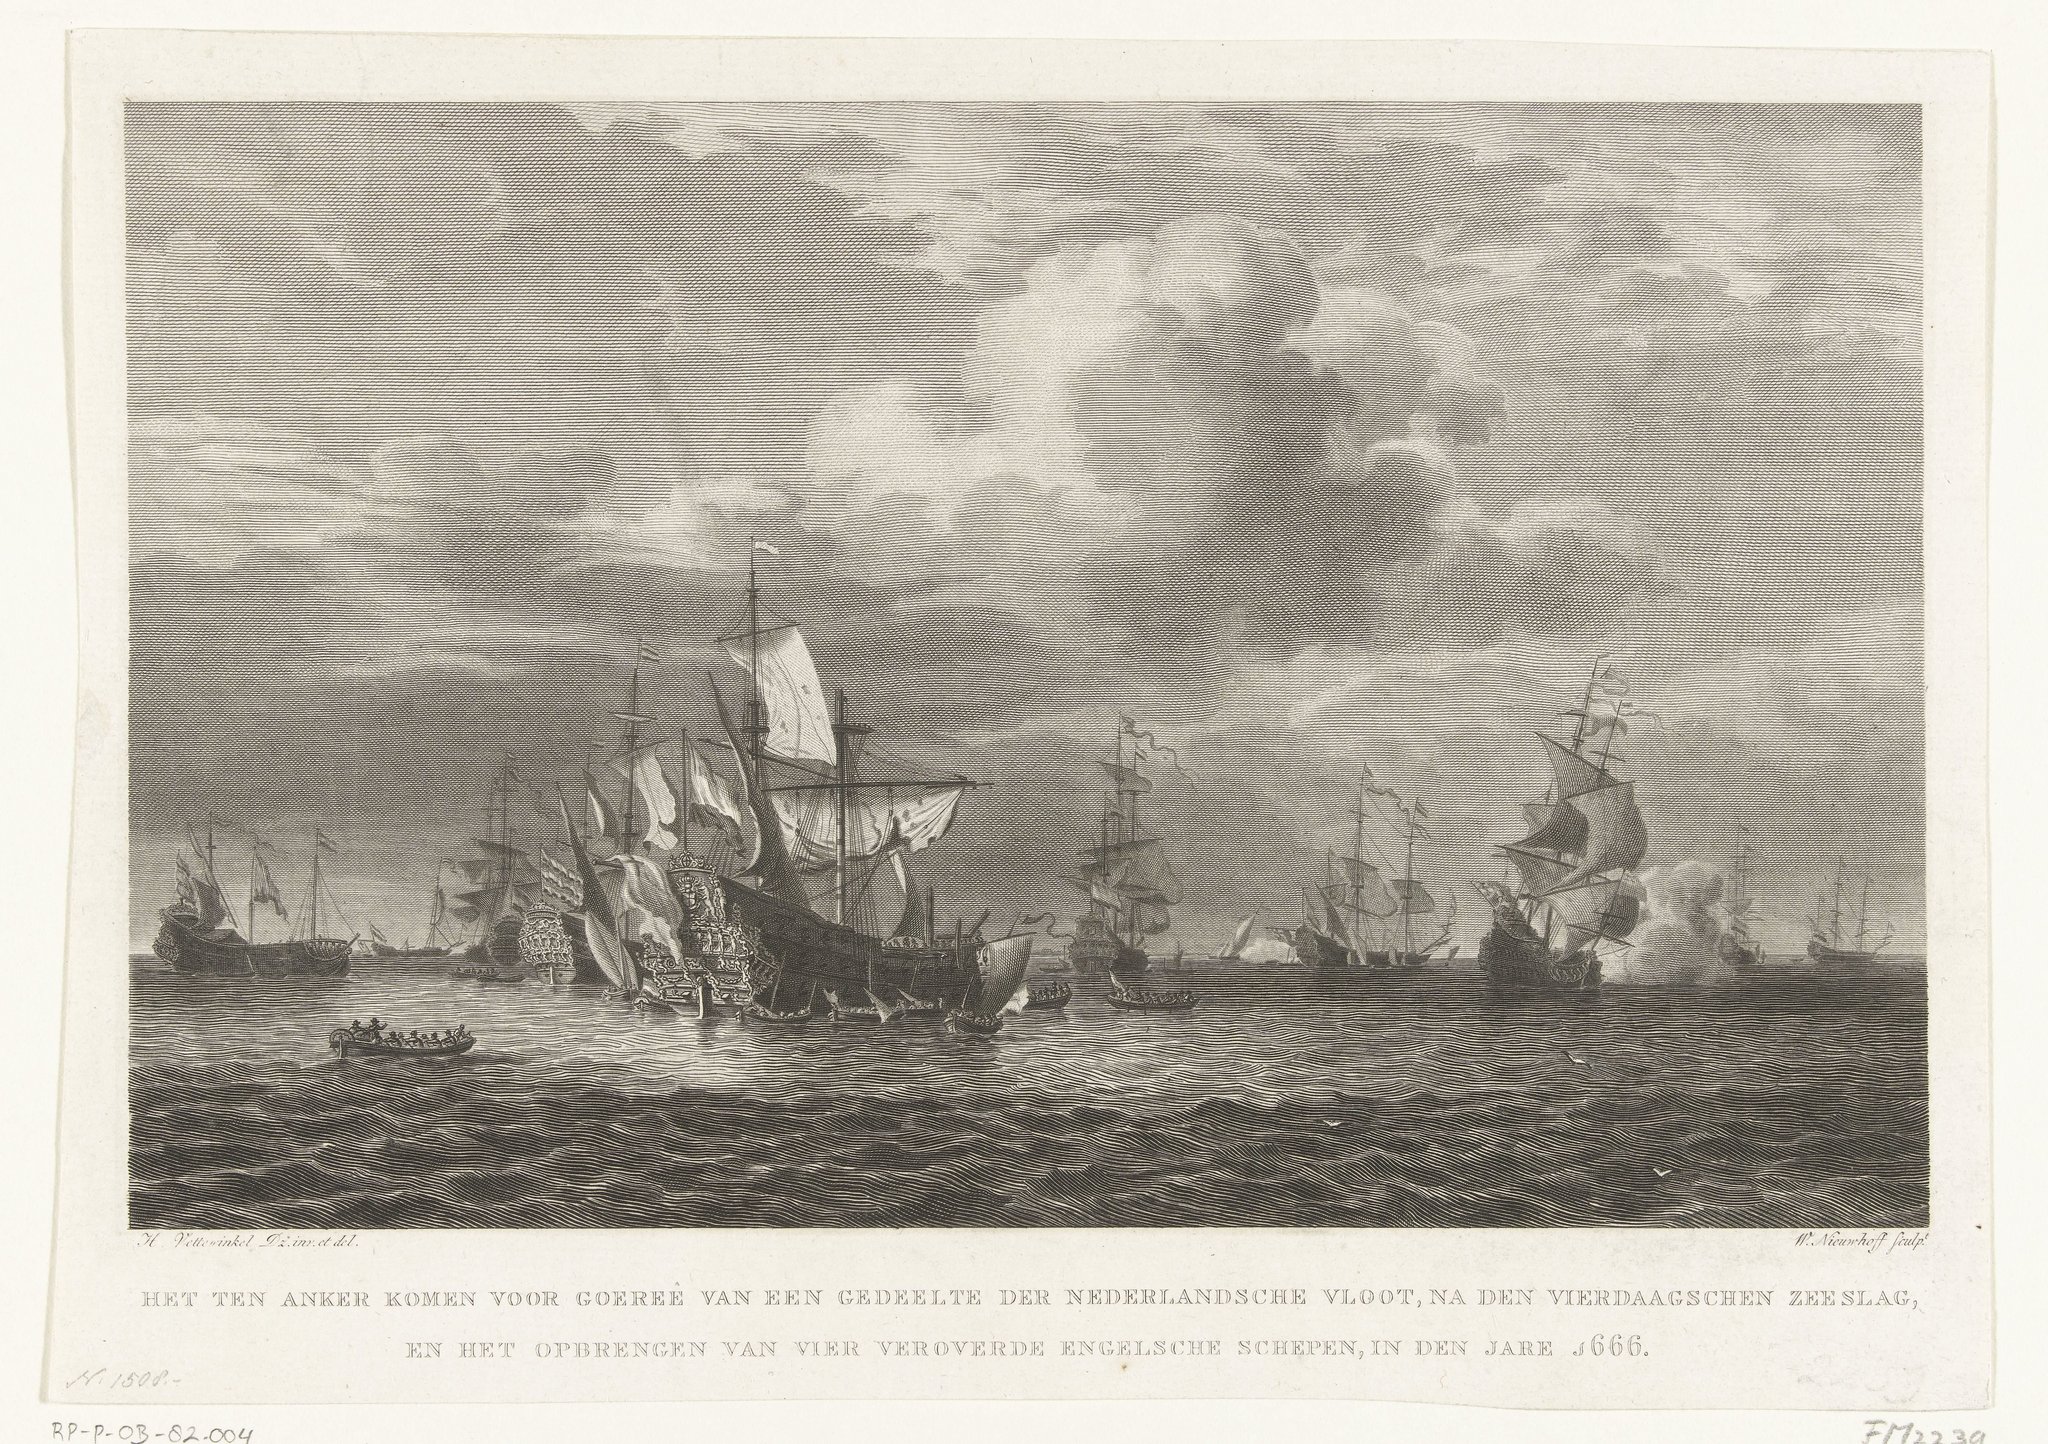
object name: history print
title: Het ten anker komen voor Goeree van een gedeelte der Nederlandsche vloot, na den vierdaagschen zeeslag, en het opbrengen van vier veroverde Engelsche schepen, in den jare 1666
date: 1829-1831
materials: paper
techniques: engraving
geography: netherlands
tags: flushing, michiel adriaenszoon de ruyter, battle (+ naval force)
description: De vier veroverde Engelse oorlogsschepen 'Swiftsure', 'Seven Oaks', 'Loyal George' en 'Convertine' worden het Goereese Gat binnengebracht na de Vierdaagse Zeeslag, 11-14 juni 1666: episode uit de Tweede Engelse Zeeoorlog. Tal van sloepen varen bij de buitgemaakte schepen, rechts lost een Nederlands schip een salvo.